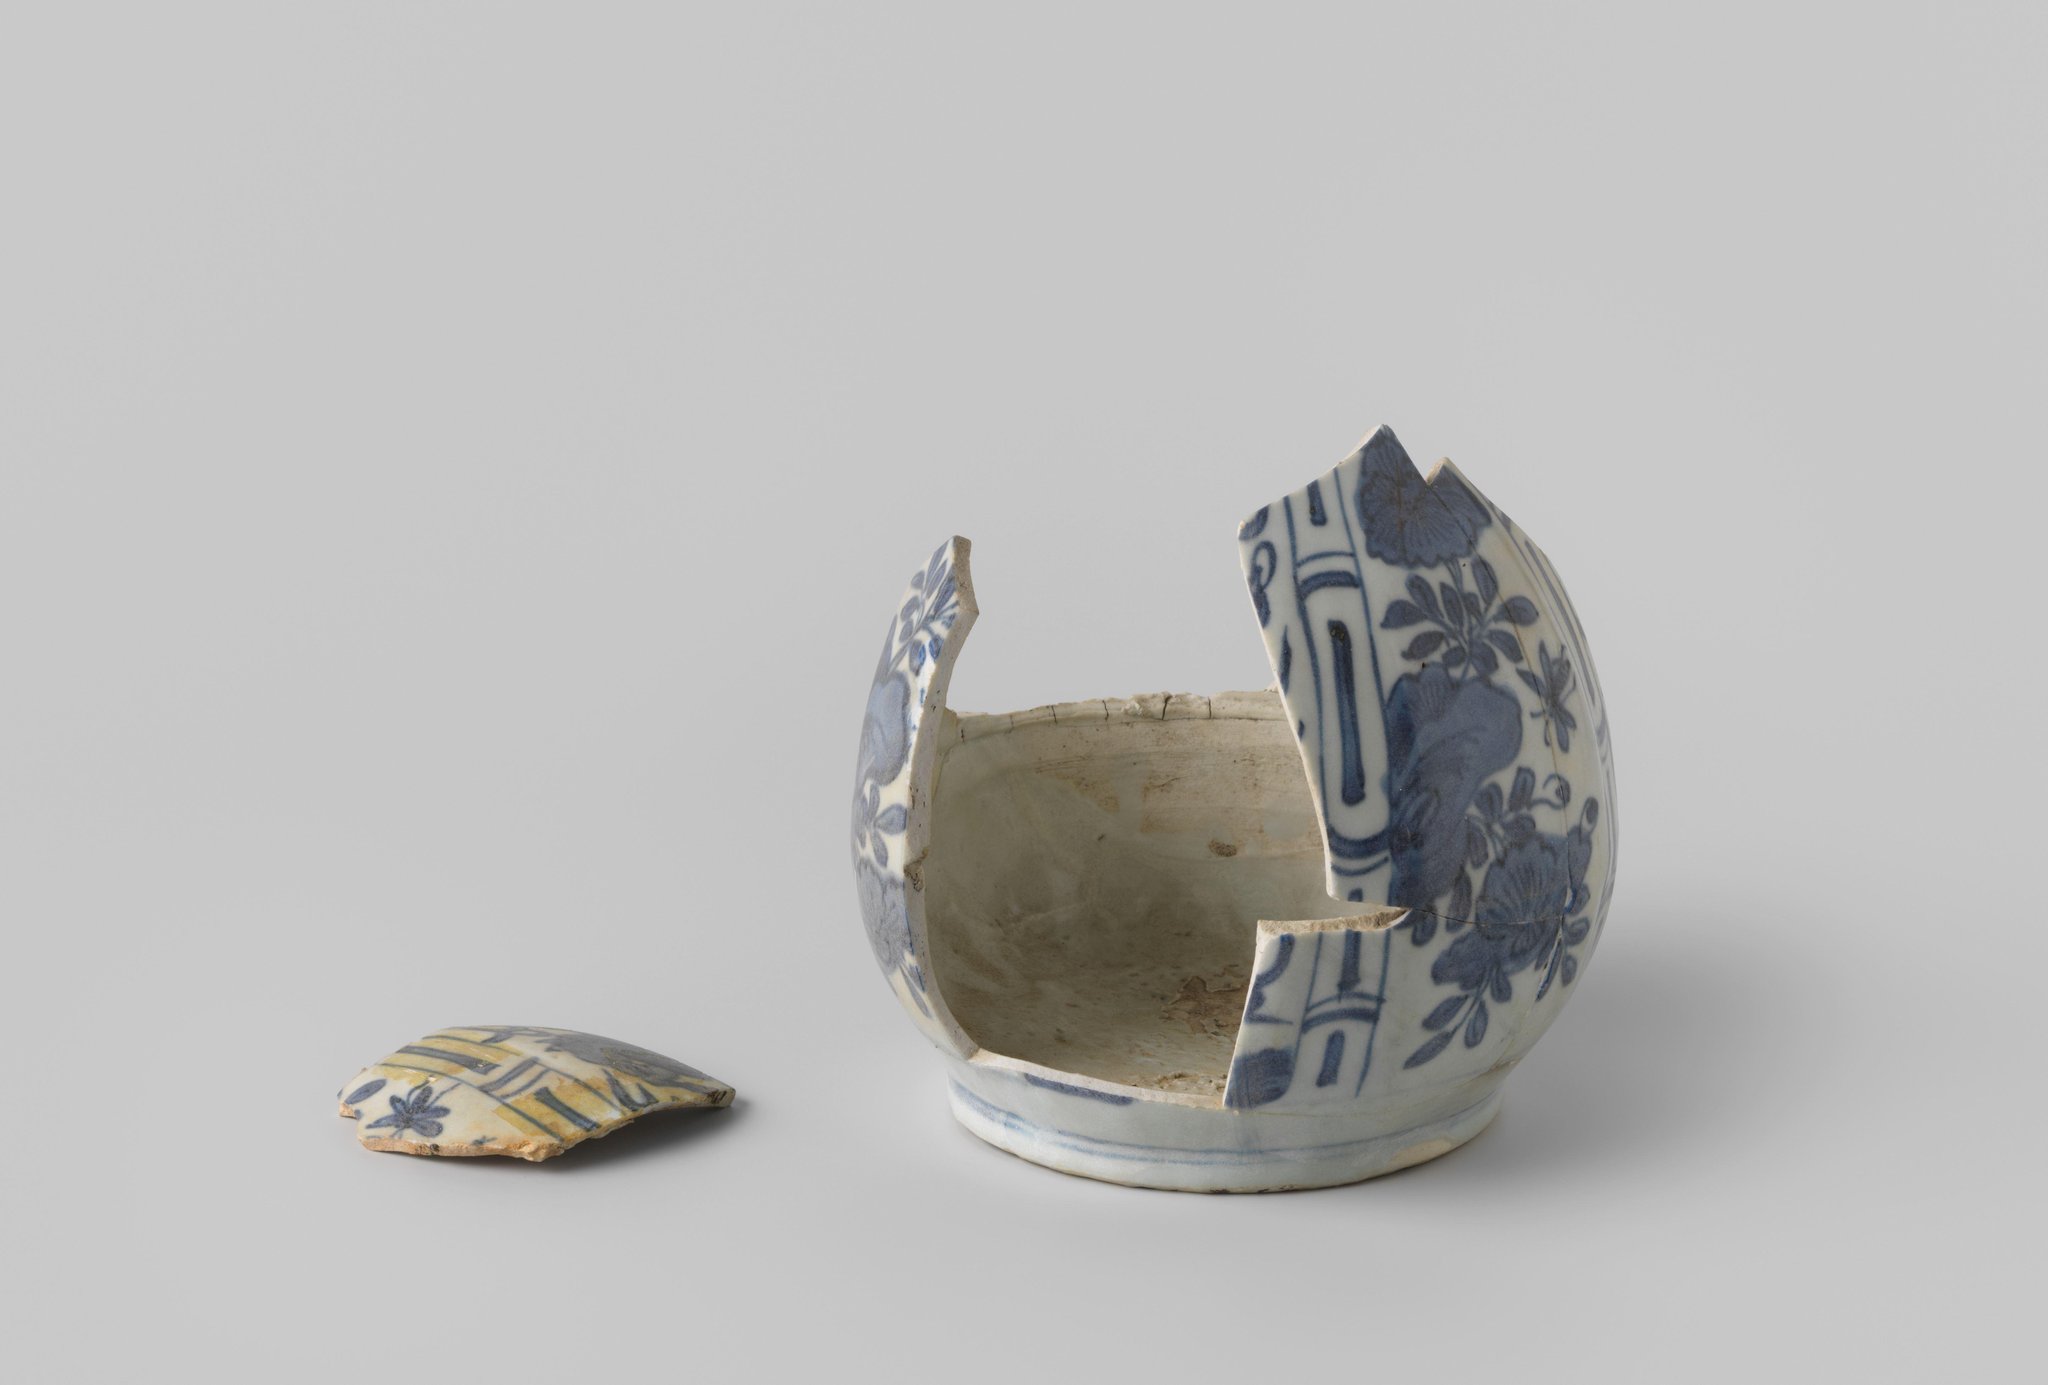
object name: pot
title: Pot uit V.O.C.-schip de 'Witte Leeuw'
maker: Anonymous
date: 1613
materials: porcelain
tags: verenigde oostindische compagnie, sint-helena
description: Pot uit V.O.C.-schip de 'Witte Leeuw'. 70% aanwezig. Eén losse scherf, de rest aan elkaar gelijmd.